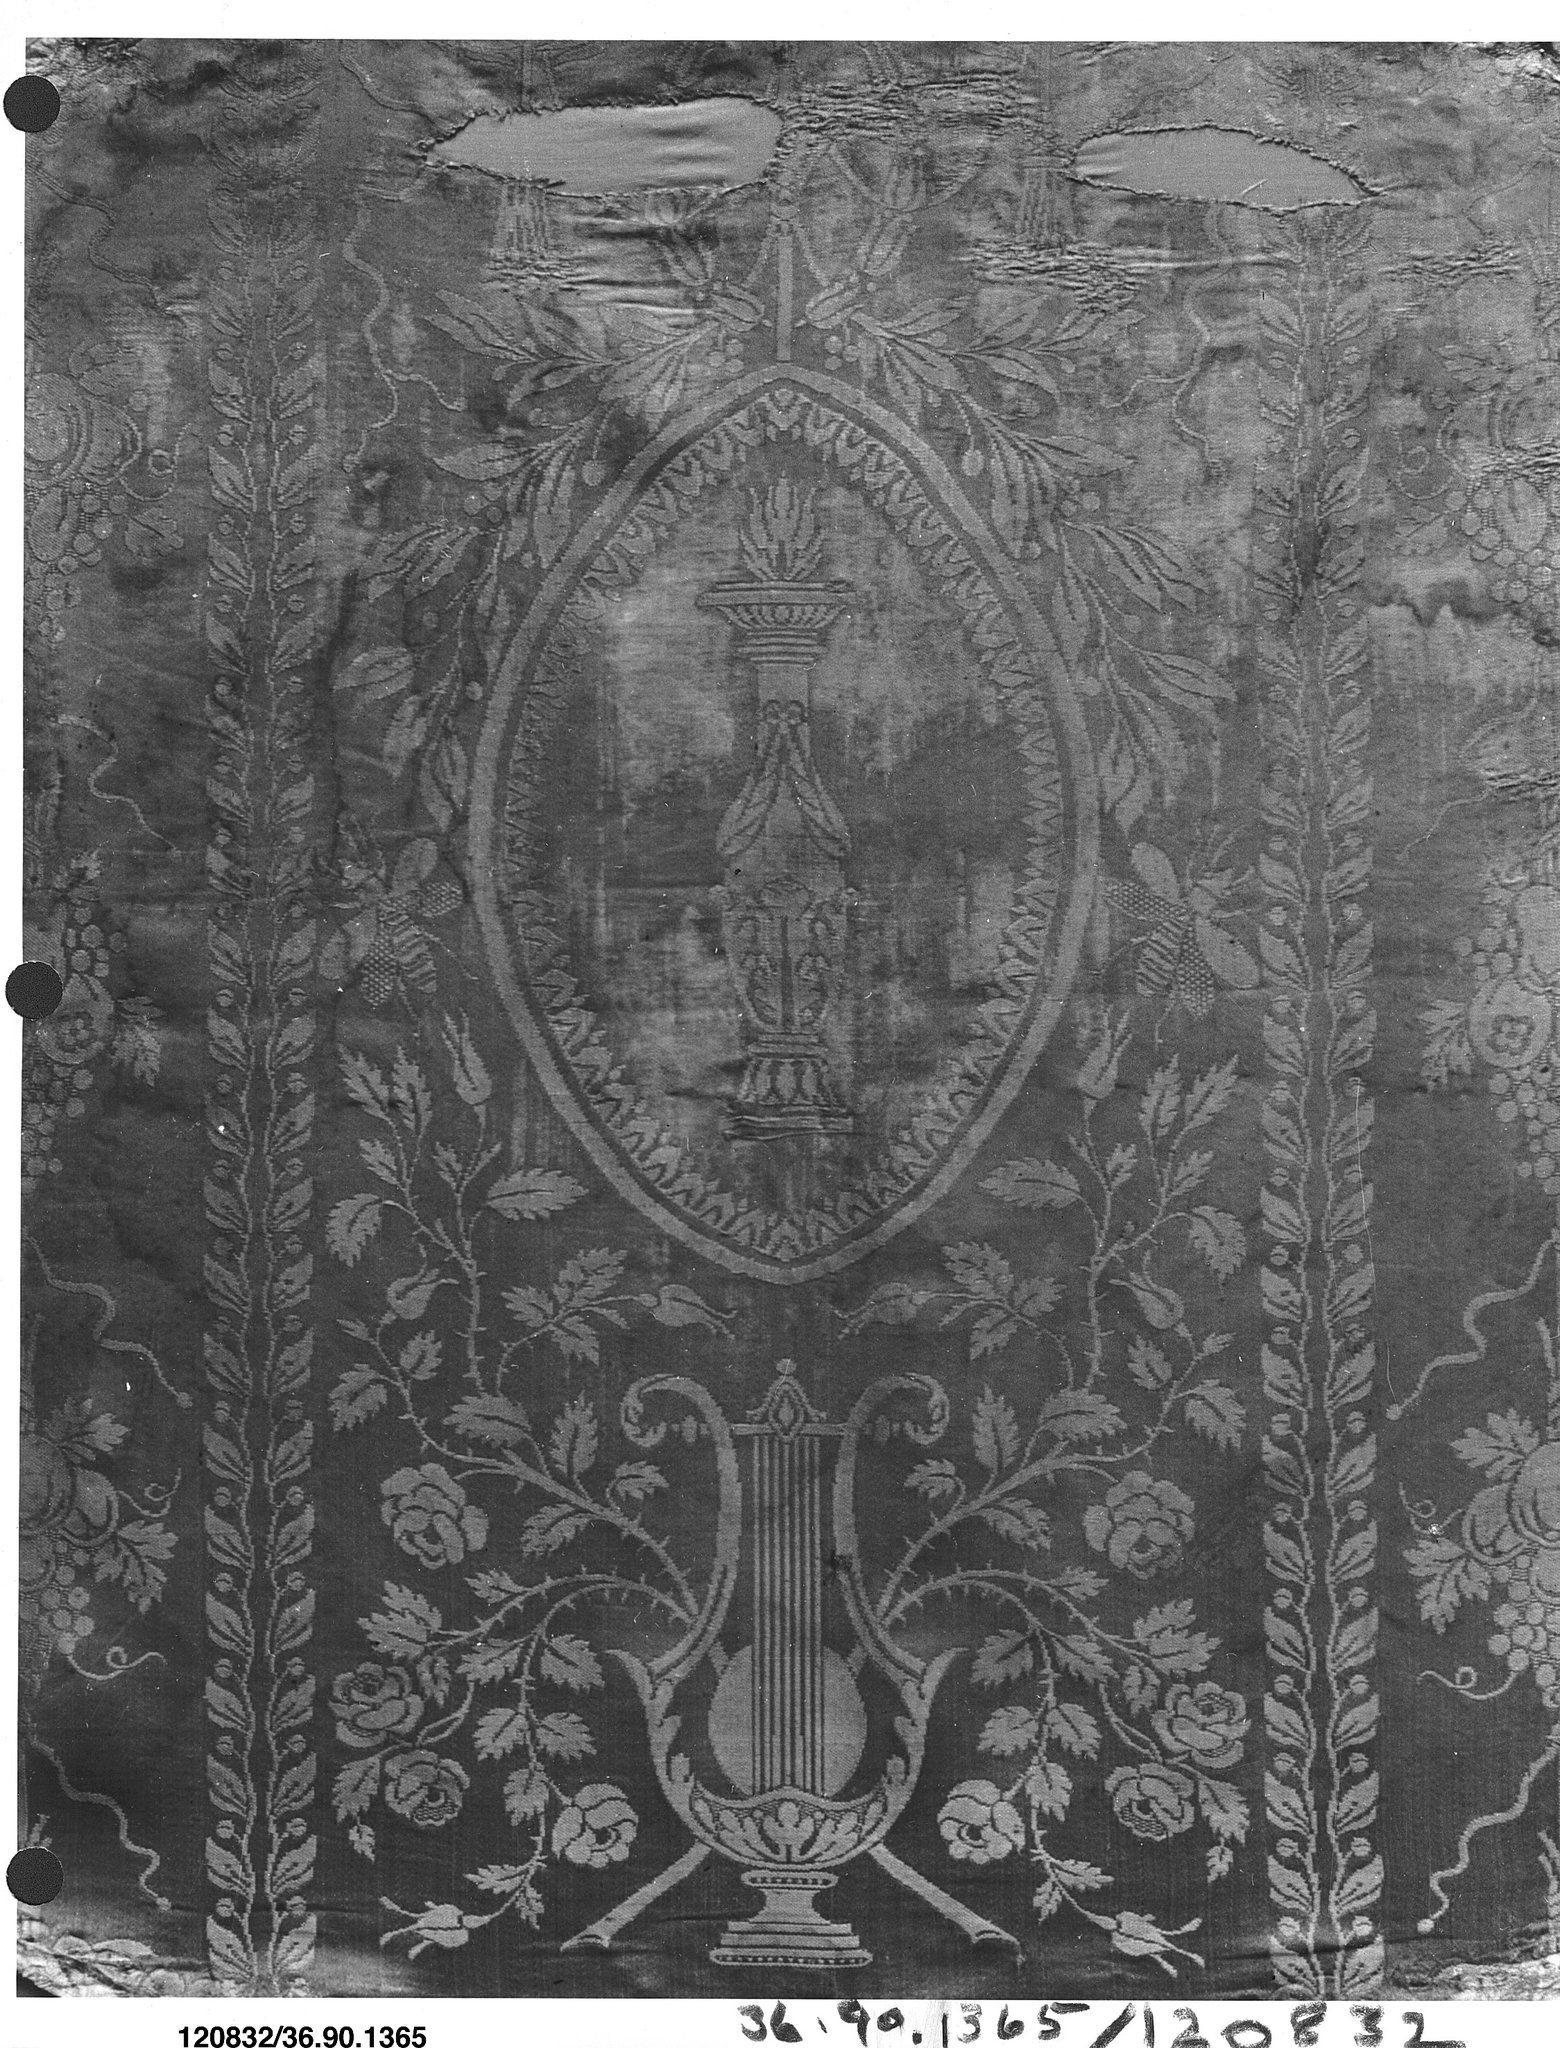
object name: piece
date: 1767-1800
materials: silk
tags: roses,lyres